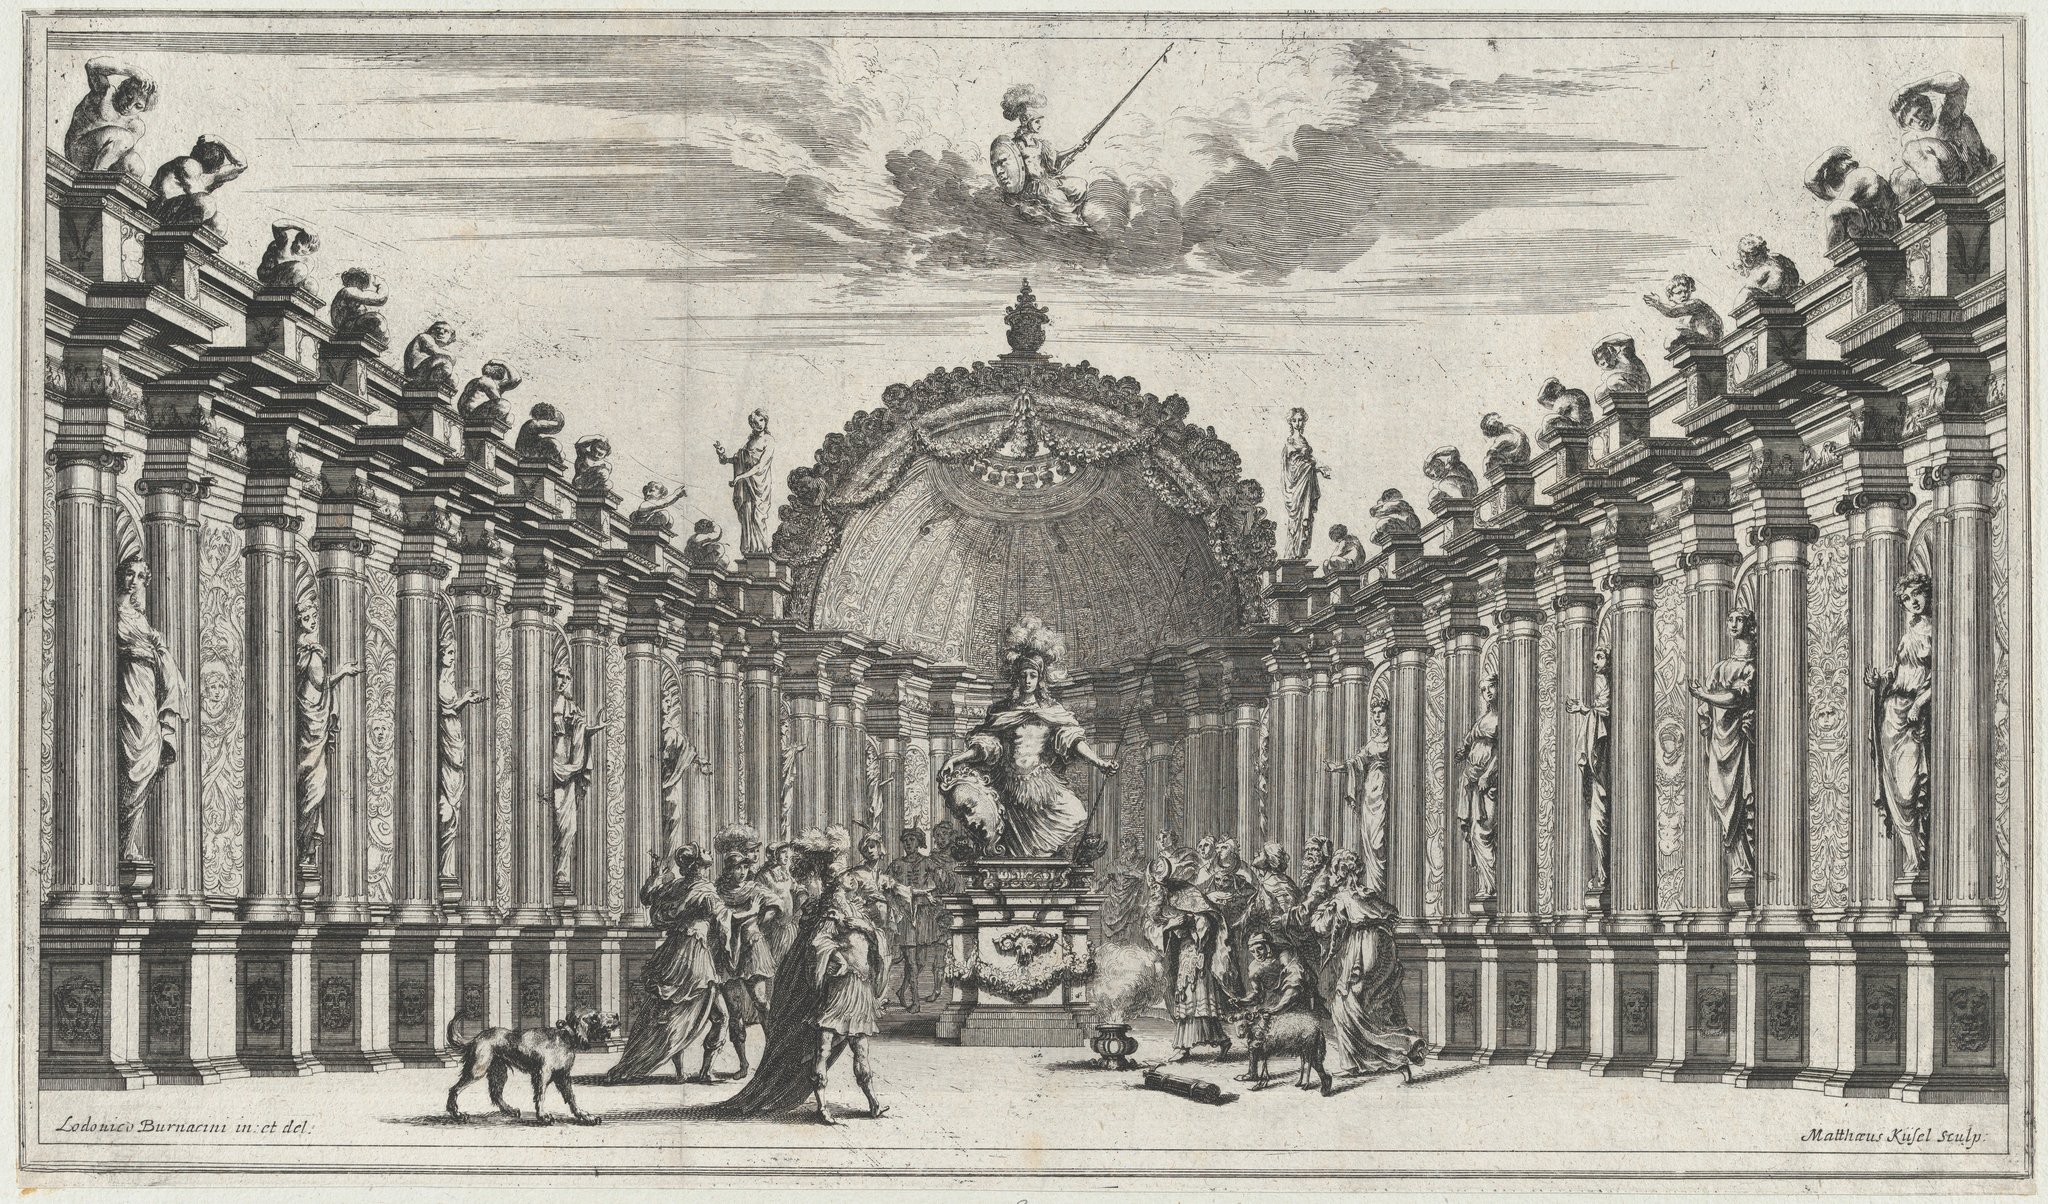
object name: print, fete, ornament architecture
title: Figures worshipping the statue of an armed figure; set design from 'Il Pomo D'Oro'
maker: mathäus küsel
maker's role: artist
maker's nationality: german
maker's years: 1621-1682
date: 1668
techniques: etching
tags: opera,columns,men,dogs,stage design